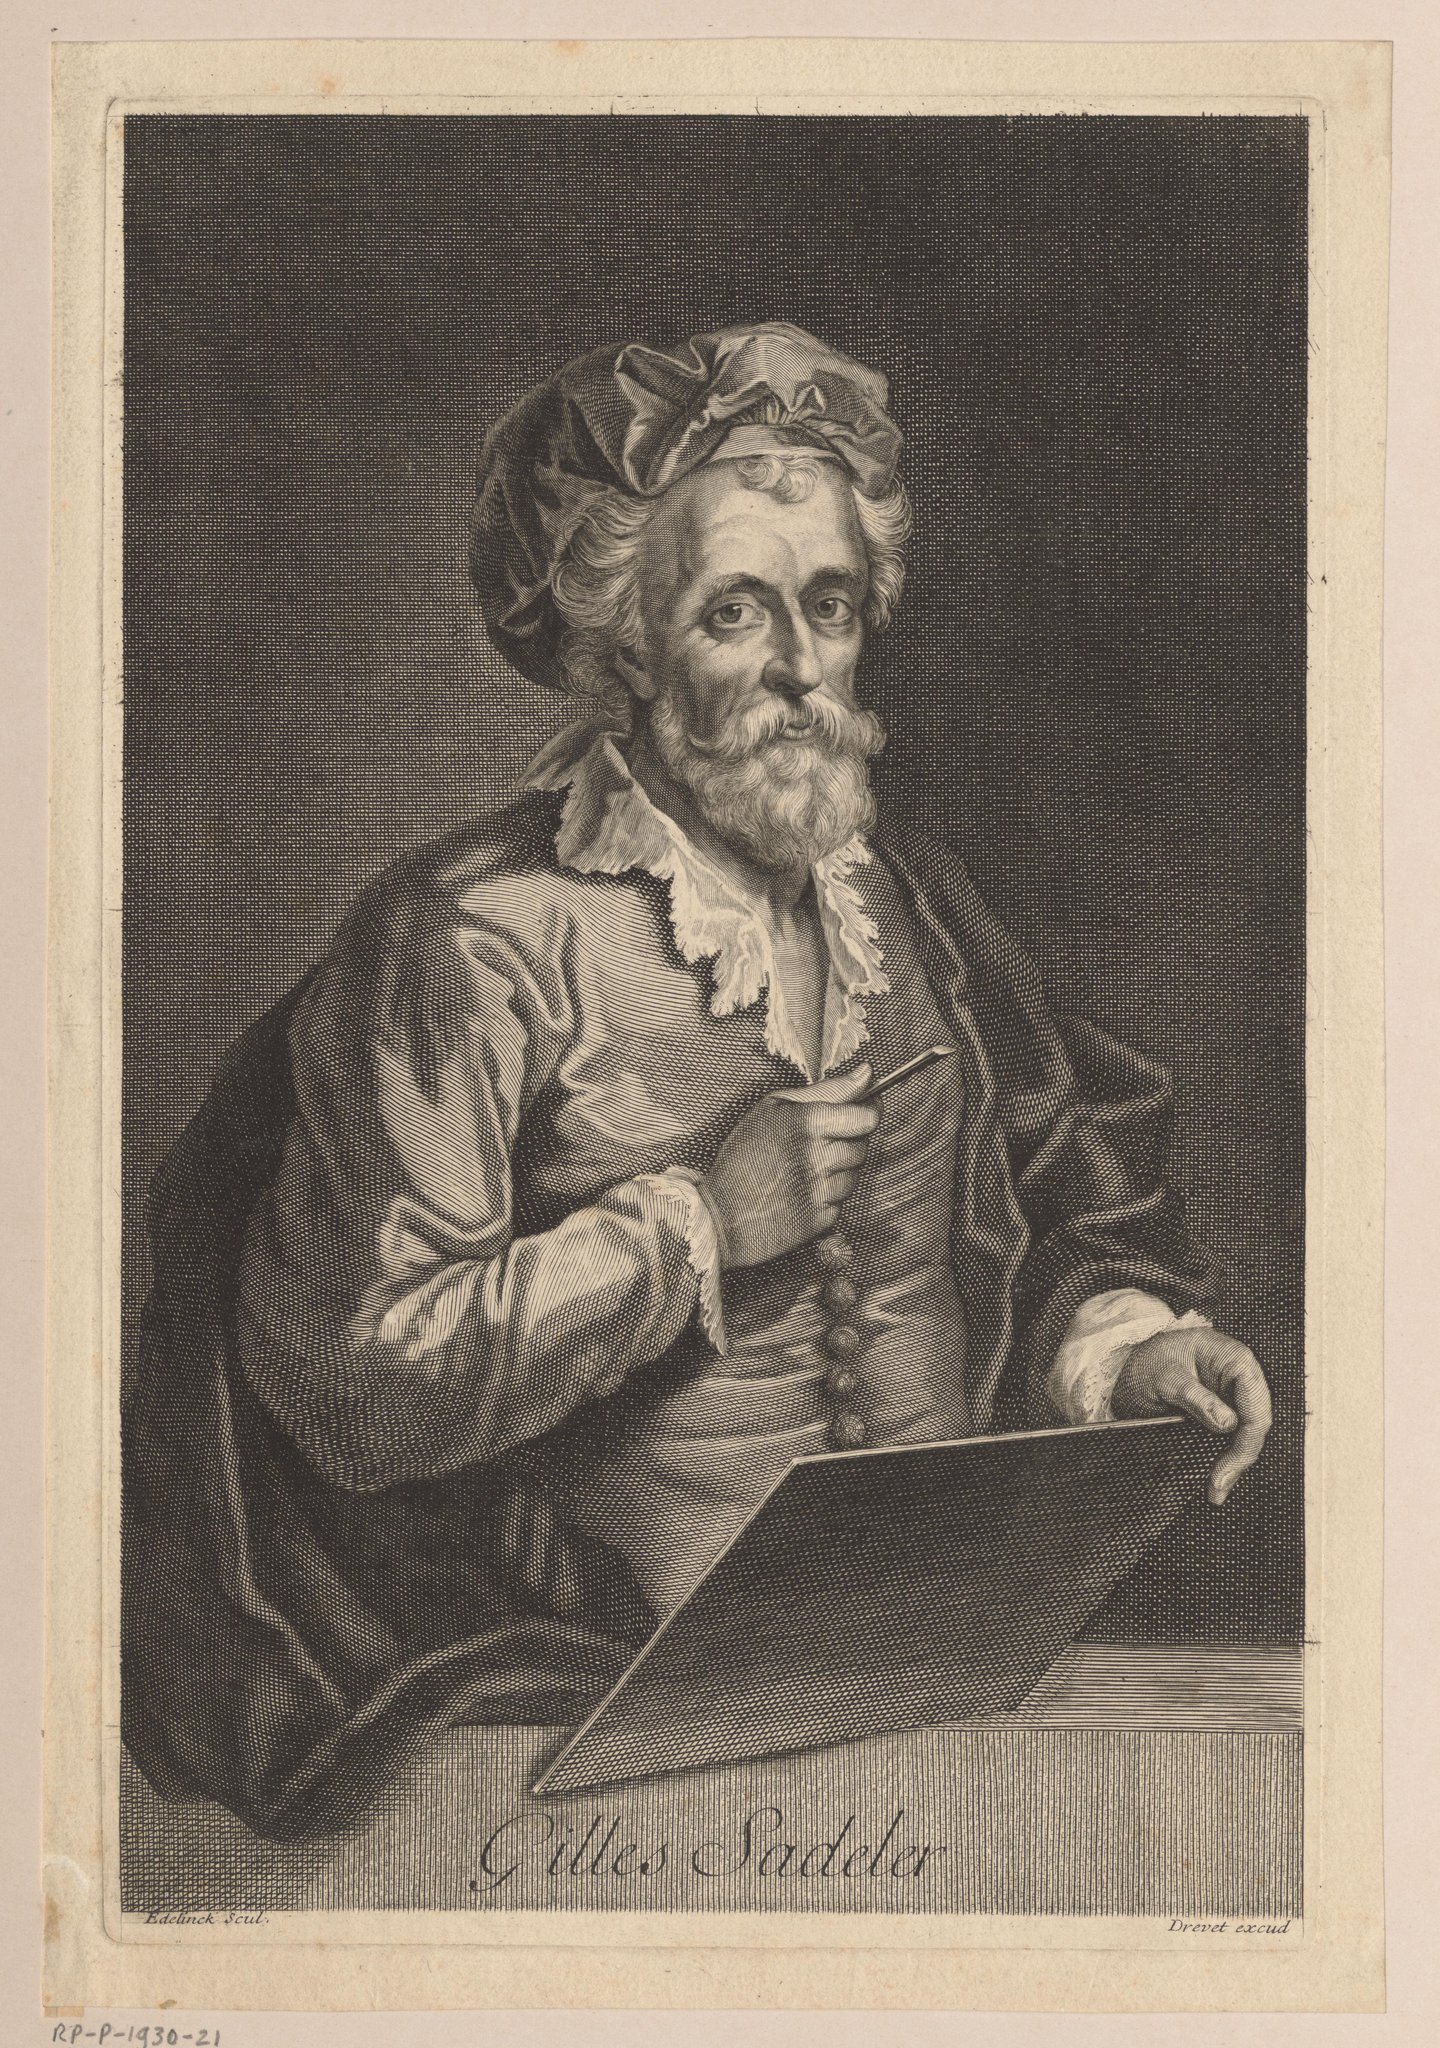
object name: print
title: Portret van Aegidius Sadeler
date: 1673-1707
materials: paper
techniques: engraving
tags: antwerp, prague, print maker, draughtsman, aegidius sadeler (ii), historical persons, tools, implements of draughtsman, portrait, self-portrait of graphic artist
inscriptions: collector's mark: Lugt 240